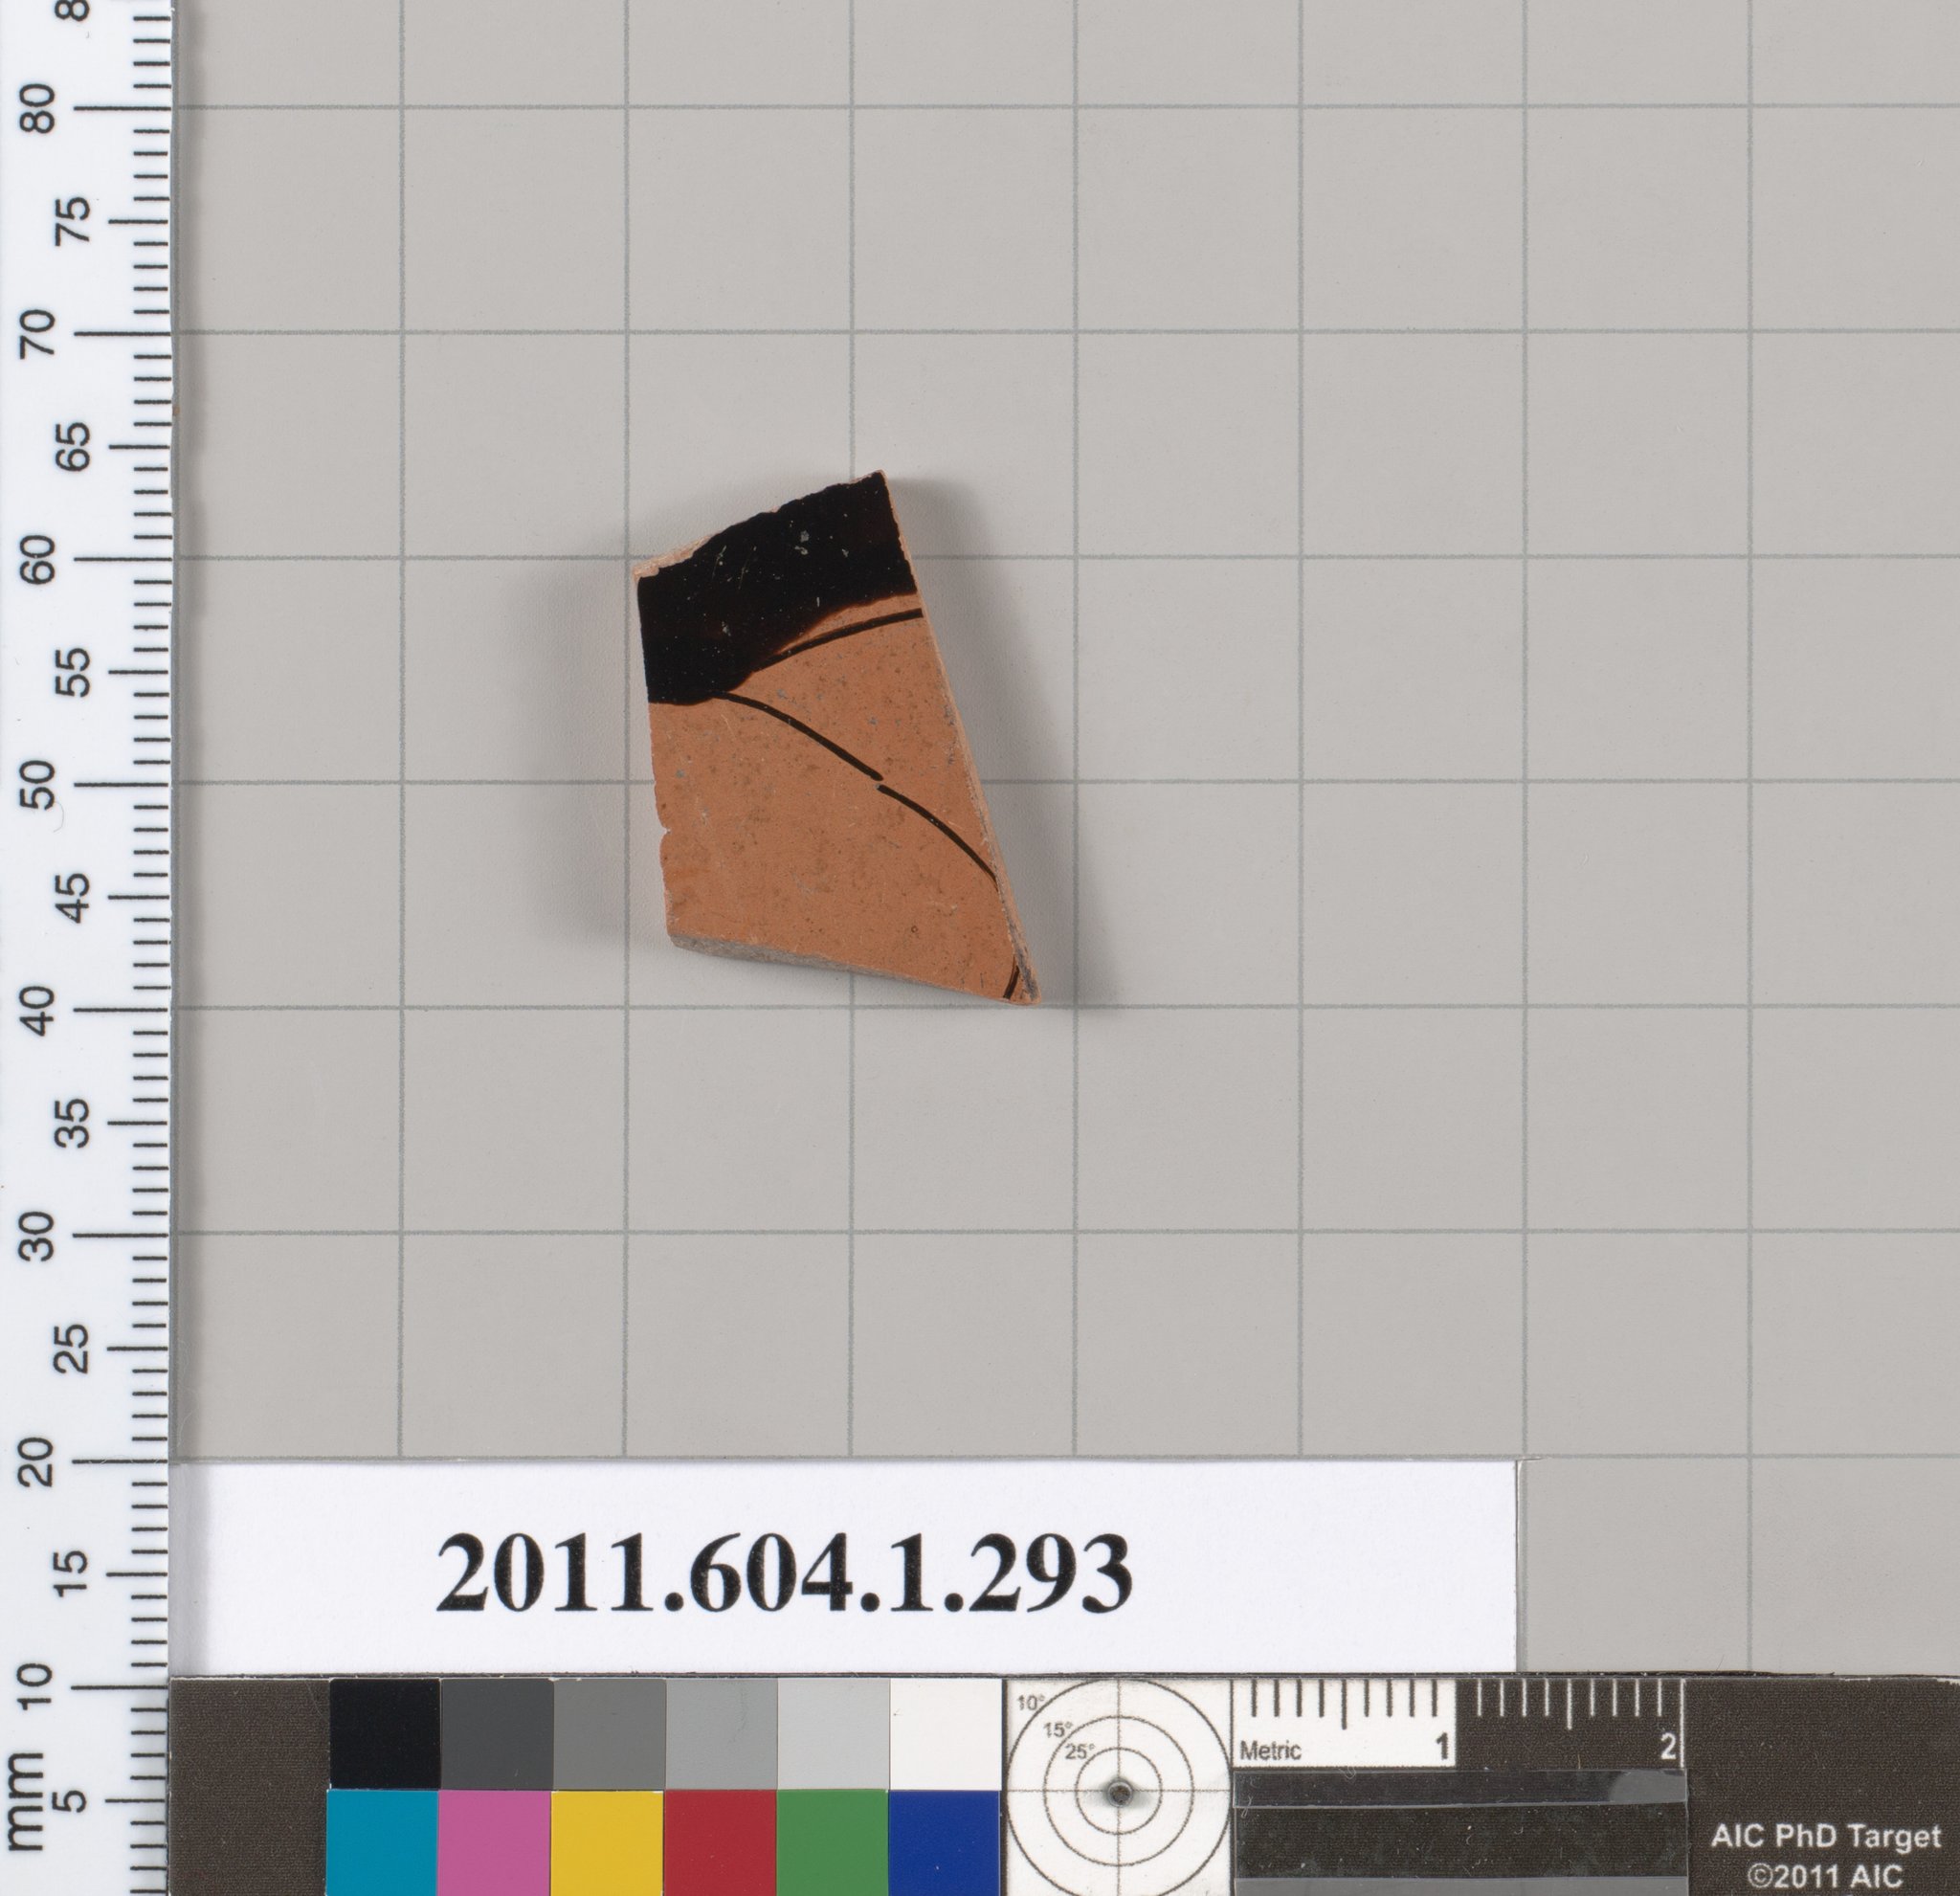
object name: kylix fragment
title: Terracotta fragment of a kylix (drinking cup)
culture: greek, attic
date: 475-451 BCE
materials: terracotta